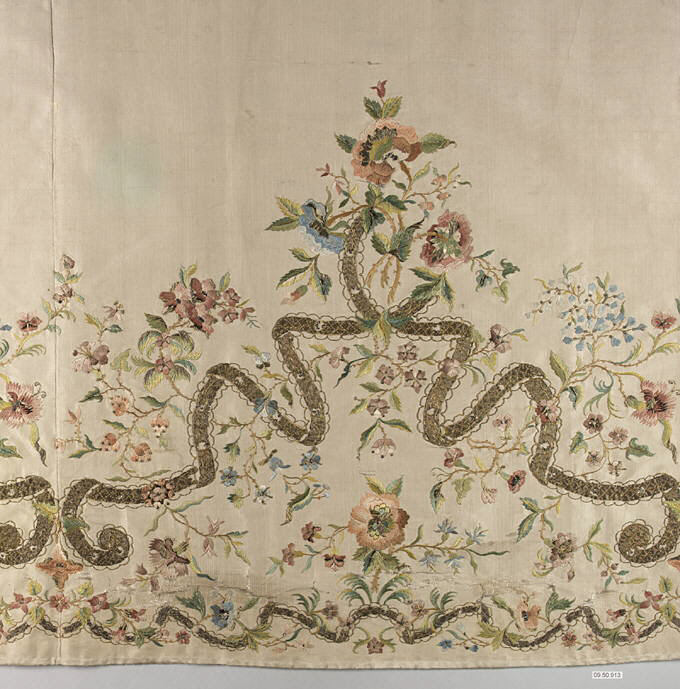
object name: border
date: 1723-1774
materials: metal thread, silk